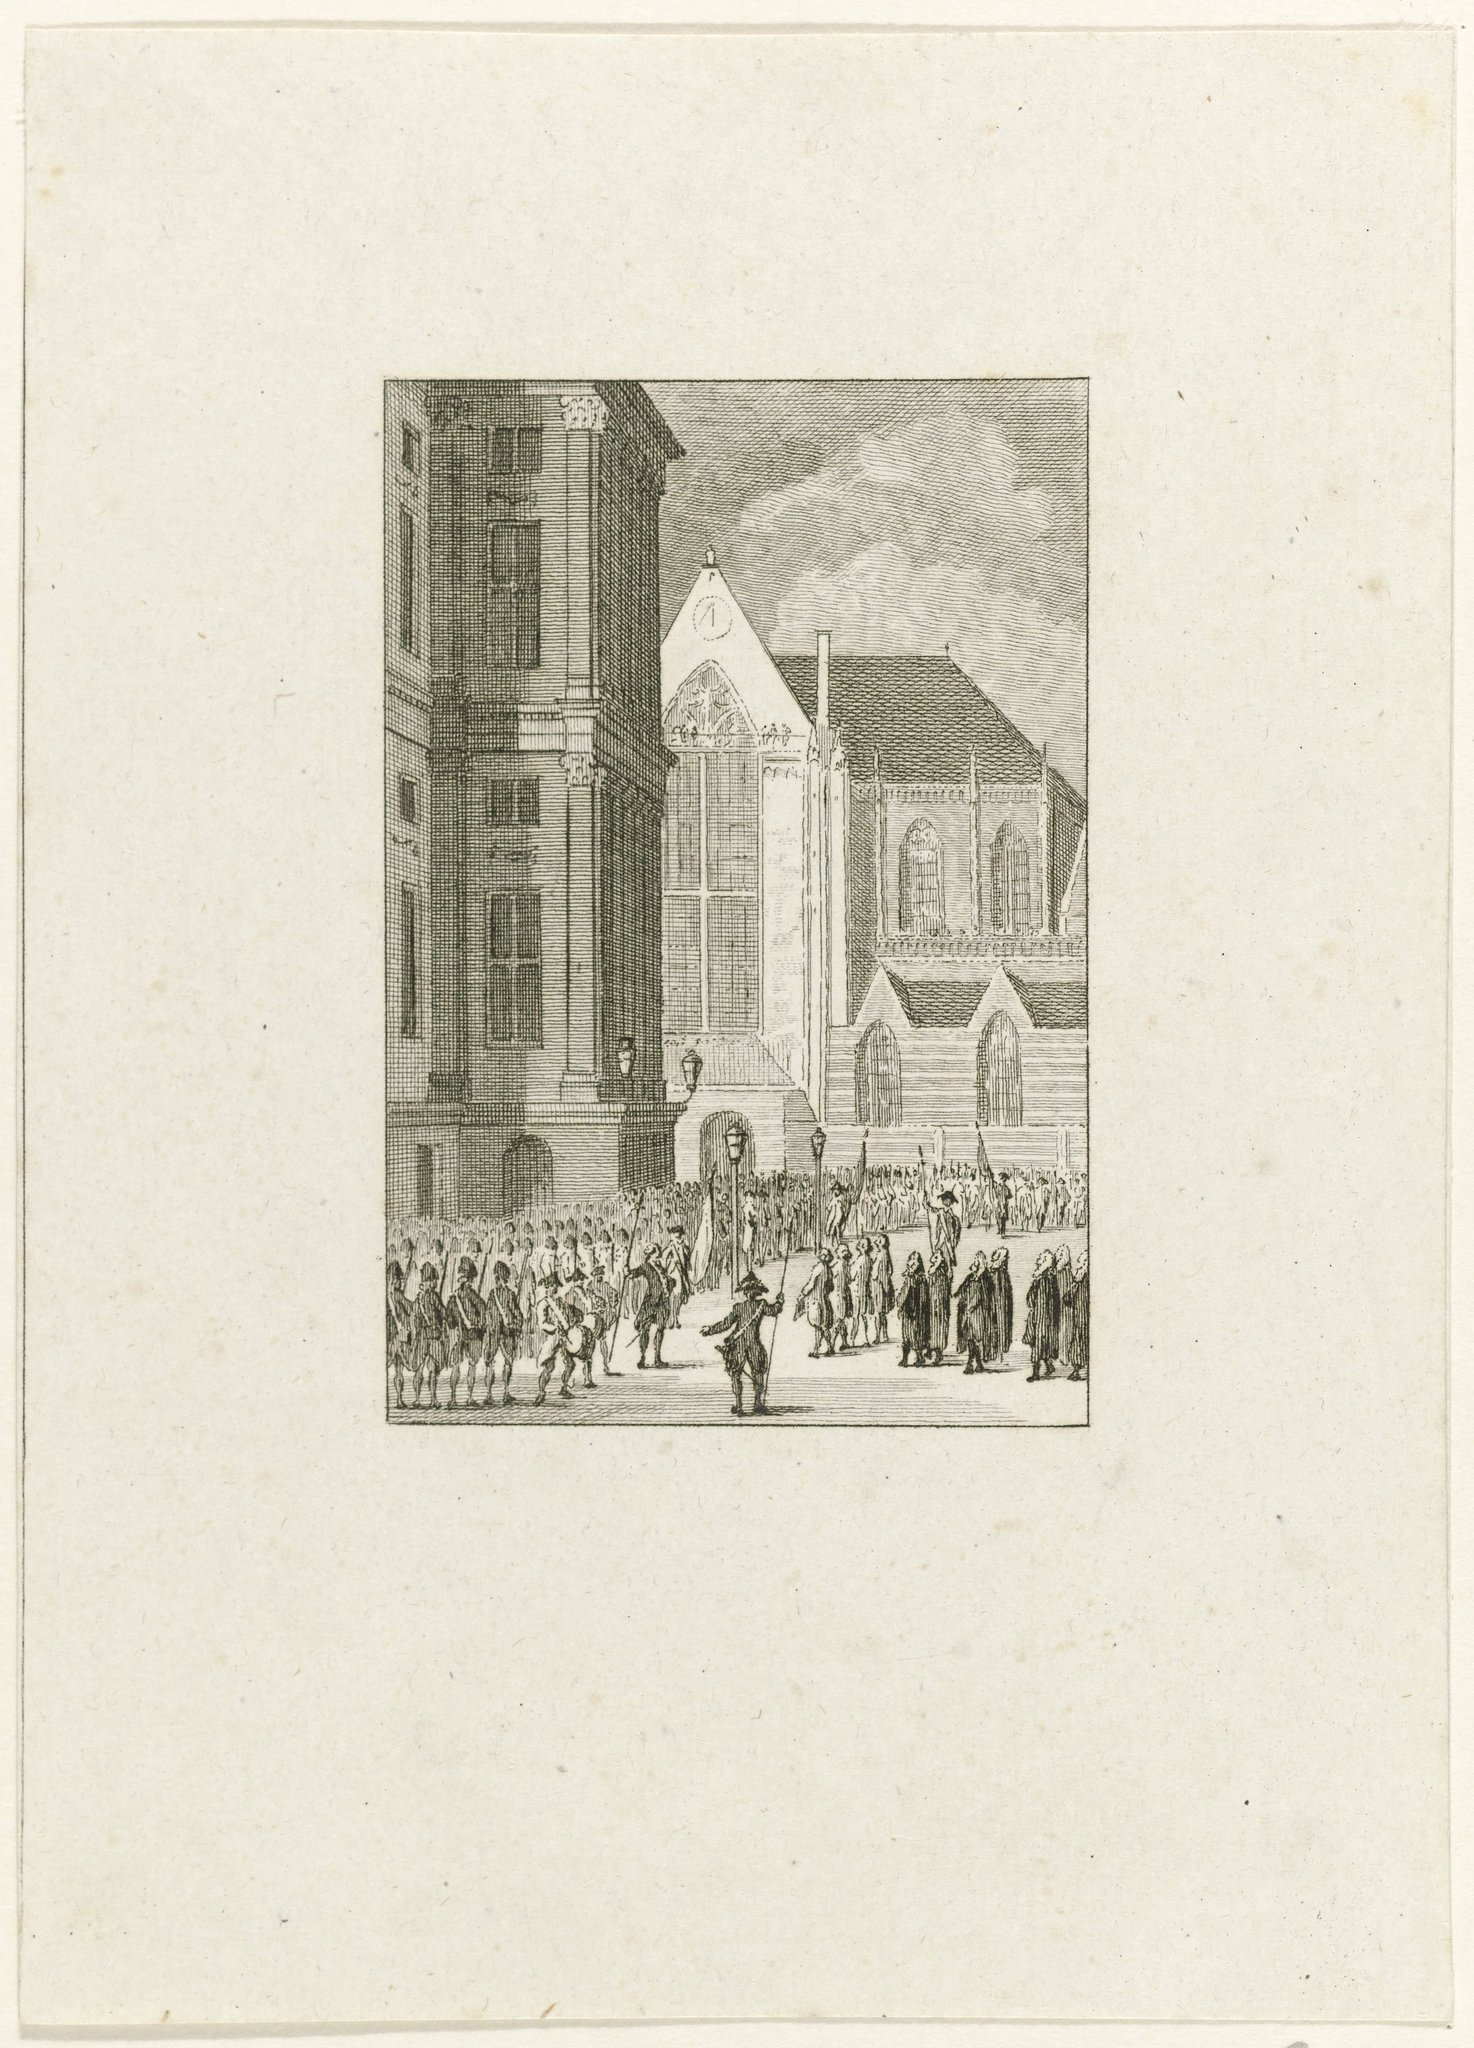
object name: print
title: Aanstelling van twee nieuwe burgemeesters te Amsterdam, 1787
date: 1787-1795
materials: paper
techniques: engraving, etching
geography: northern netherlands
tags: nieuwe kerk, dam, stadhuis van amsterdam (1655-1808)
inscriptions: collector's mark: Lugt 2228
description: Plechtige ceremonie voor een groot publiek op de Dam voor het stadhuis bij de verkiezing van twee nieuwe burgemeesters te Amsterdam, 7 juli 1787.